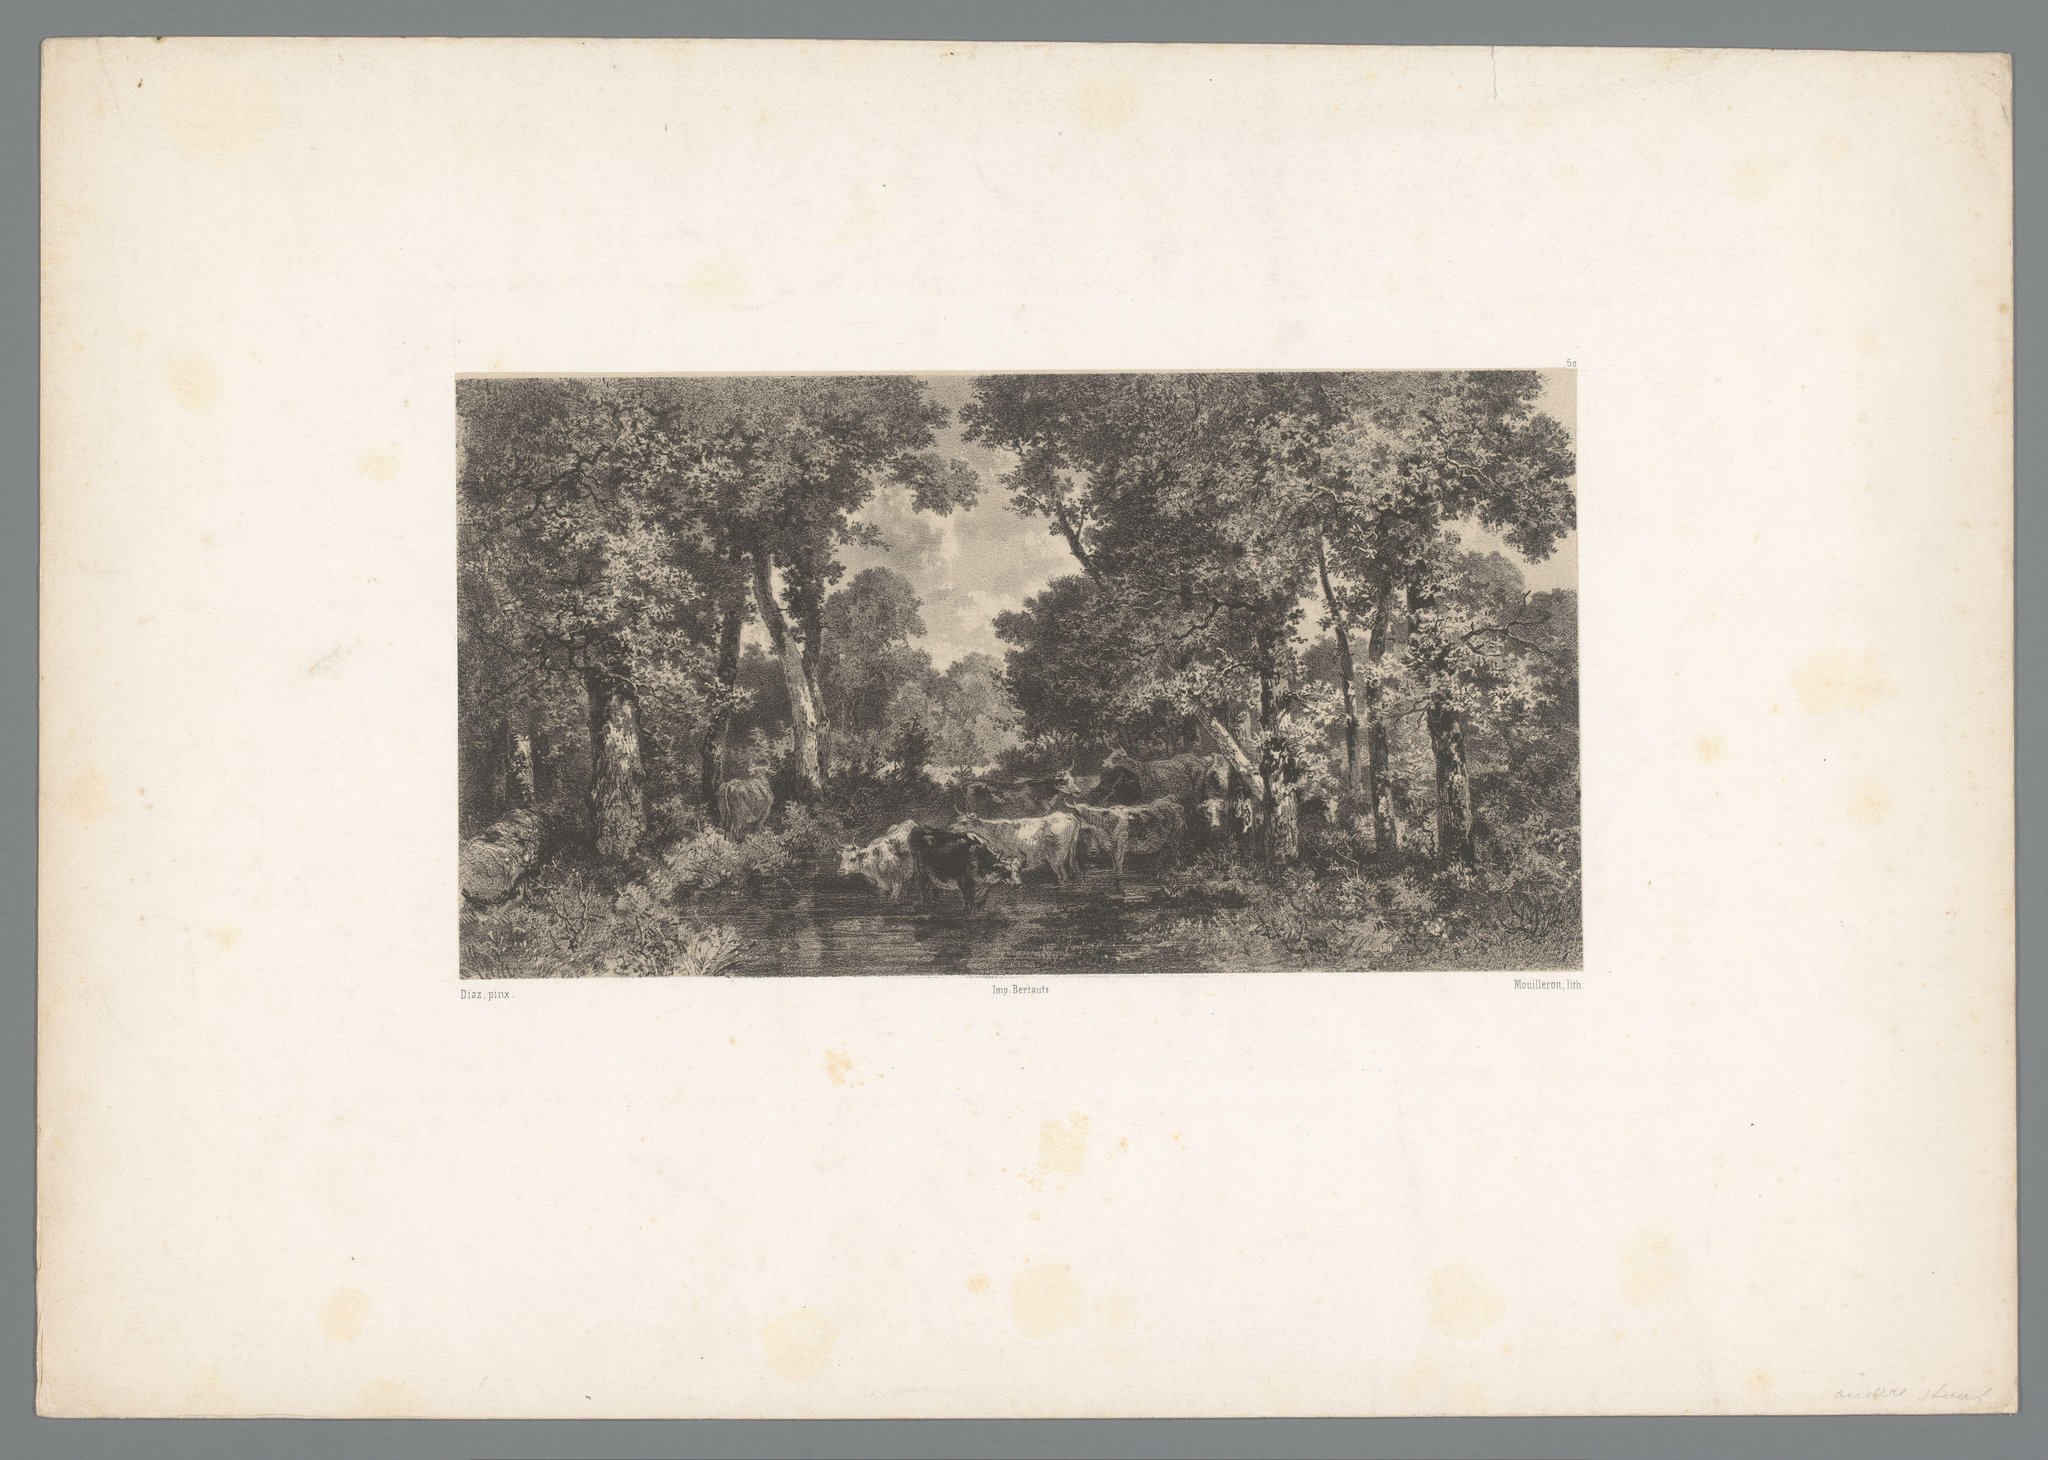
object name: print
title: Koeien bij een waterplas in een bos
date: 1846-1853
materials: paper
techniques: lithograph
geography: paris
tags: cow, pond, pool - hh - ideal landscapes, forest, wood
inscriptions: collector's mark: Lugt 2228, check stamp: Lugt 36b